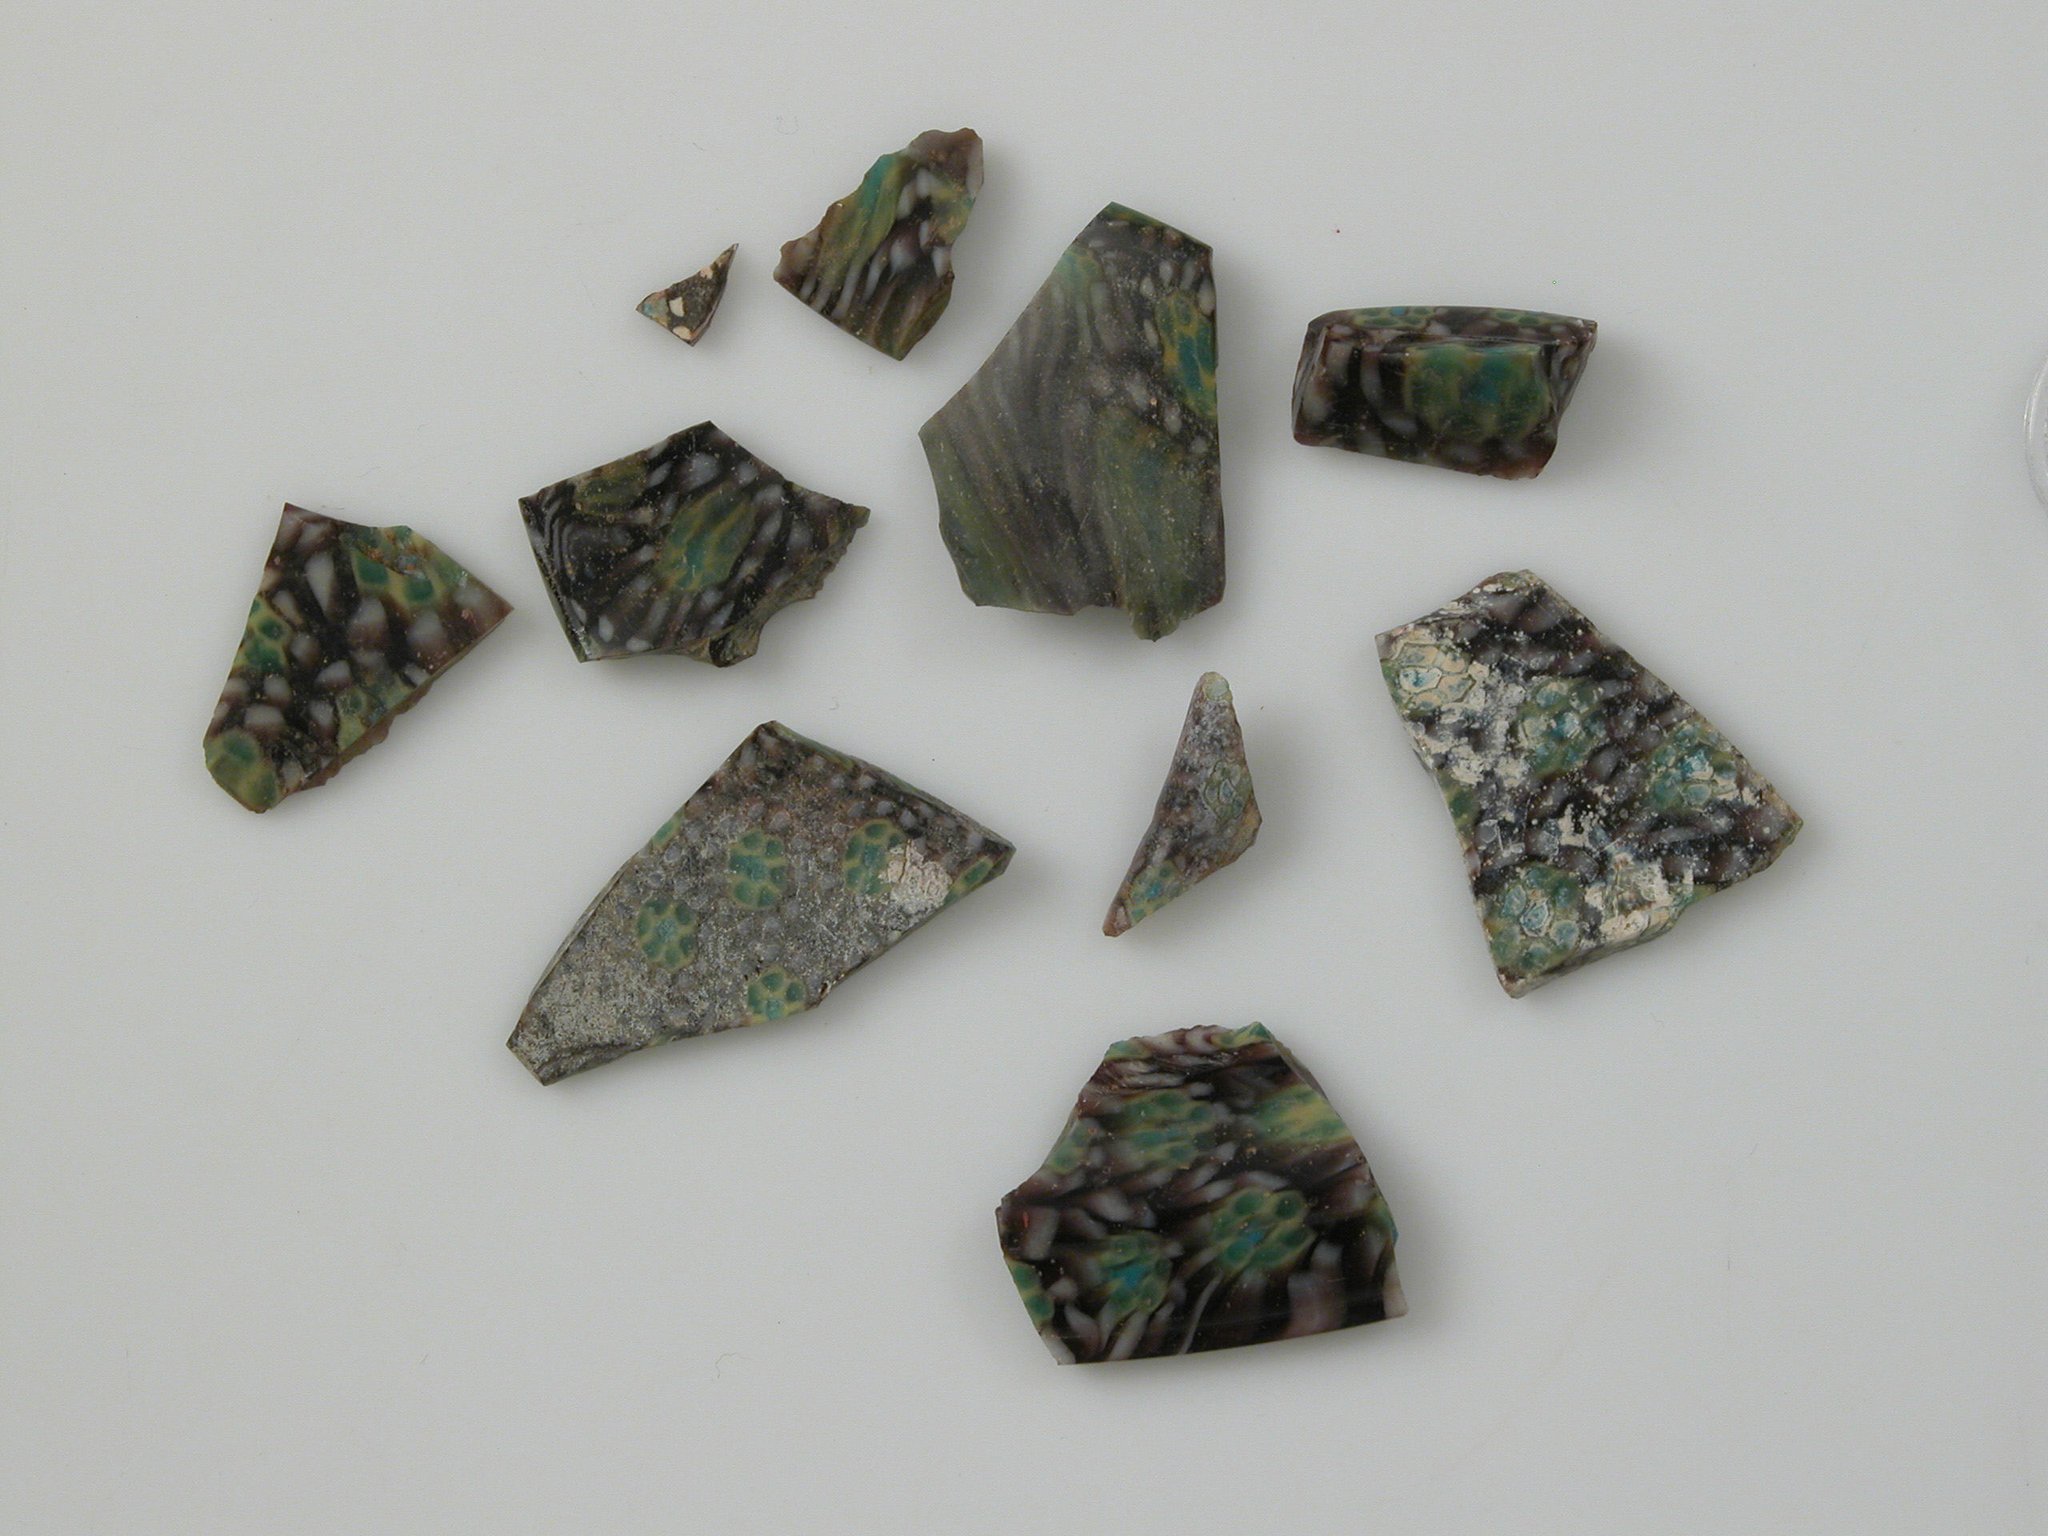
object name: fragment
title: Glass Fragments from a Vessel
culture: coptic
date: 301-433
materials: glass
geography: egypt